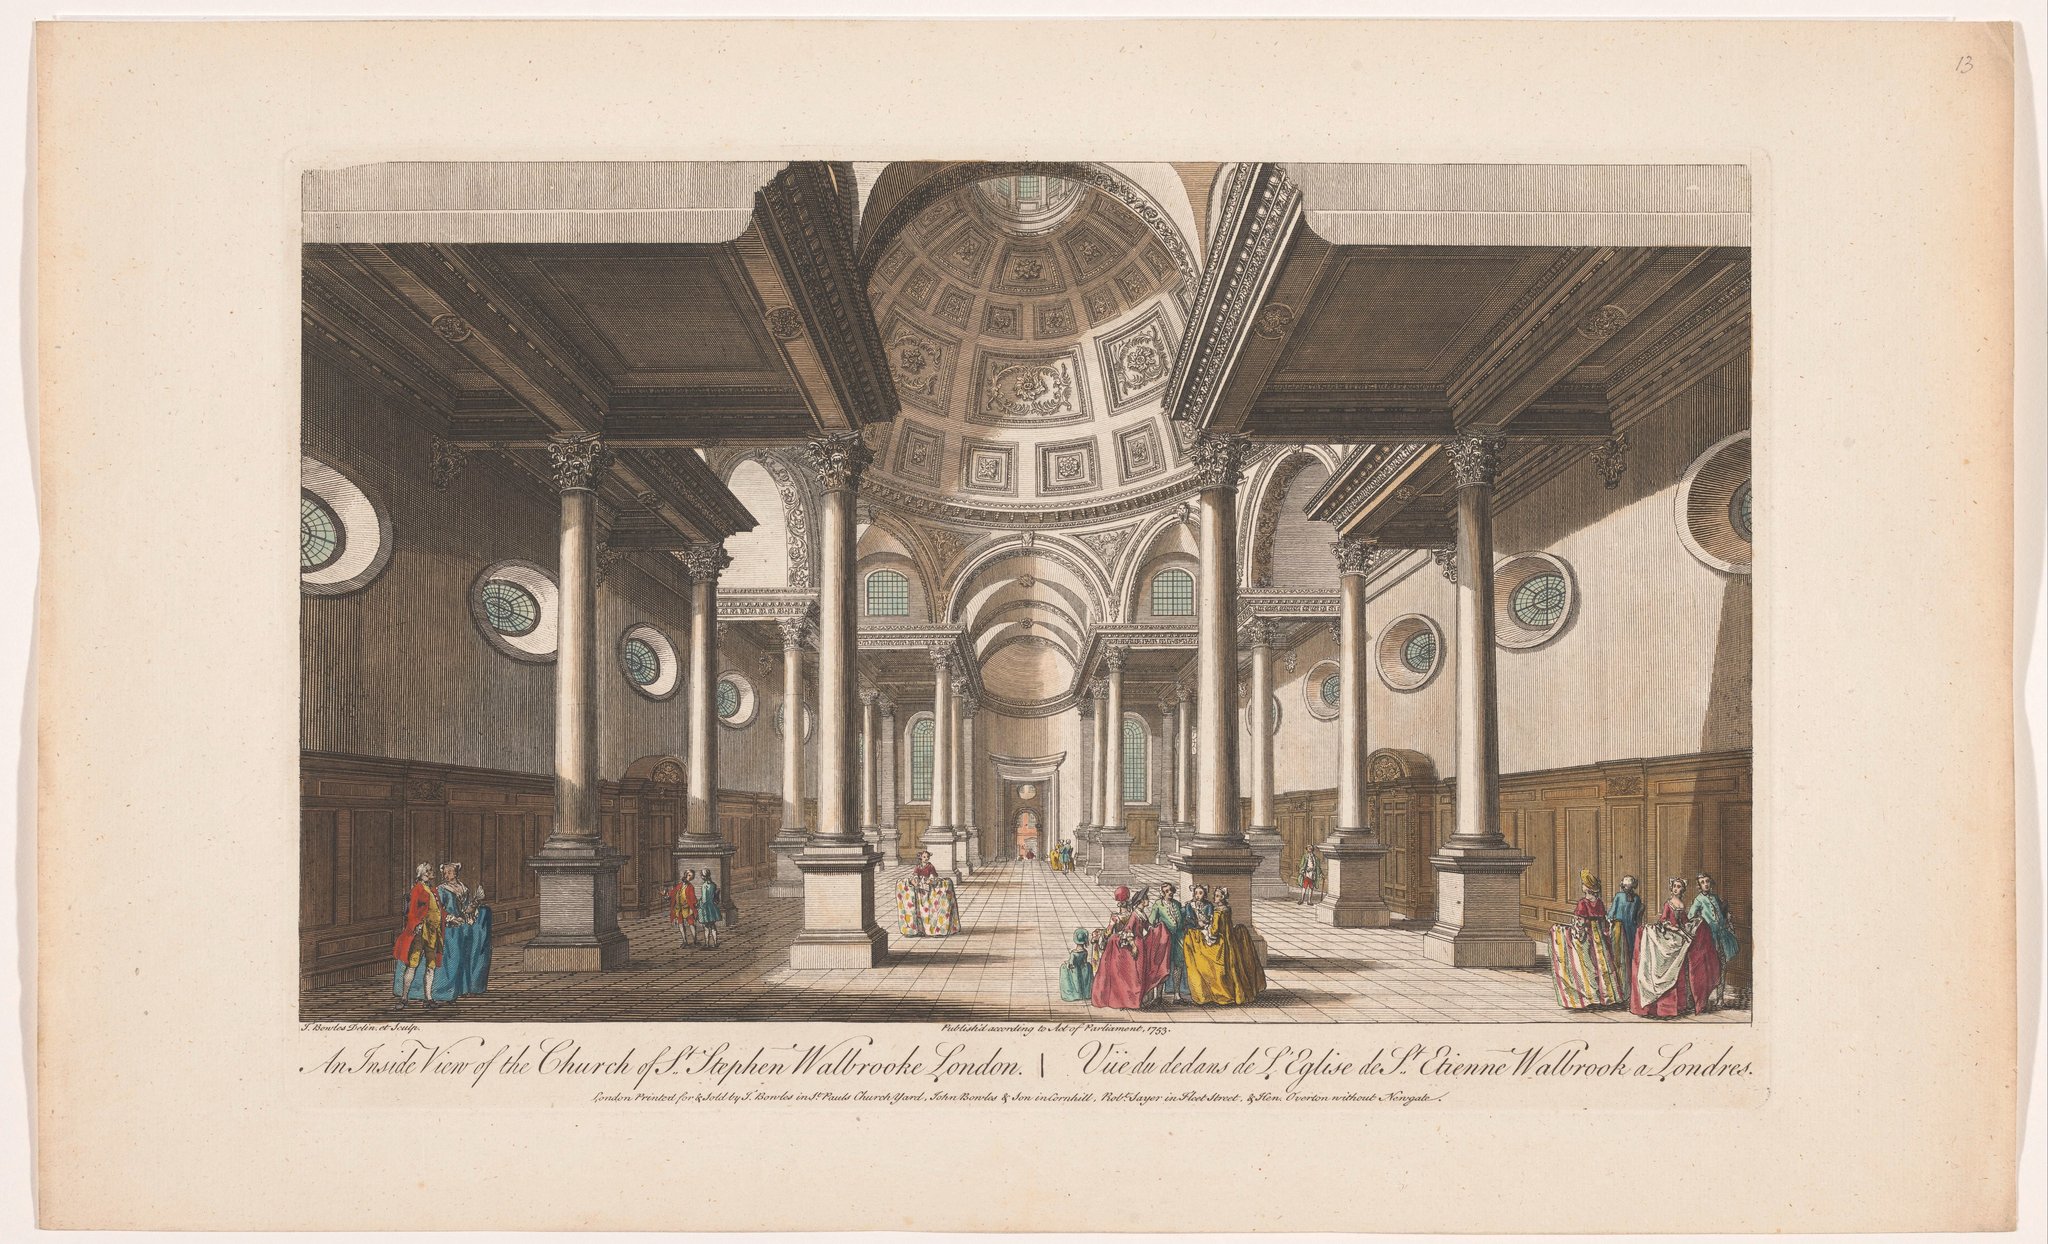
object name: print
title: Londen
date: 1753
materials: paper, watercolor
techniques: brush, etching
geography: london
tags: interior of church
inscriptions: watermark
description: De serie “Londen” bevat 52 prenten met de nummers 1-52, waarvan dit nummer 13 is.